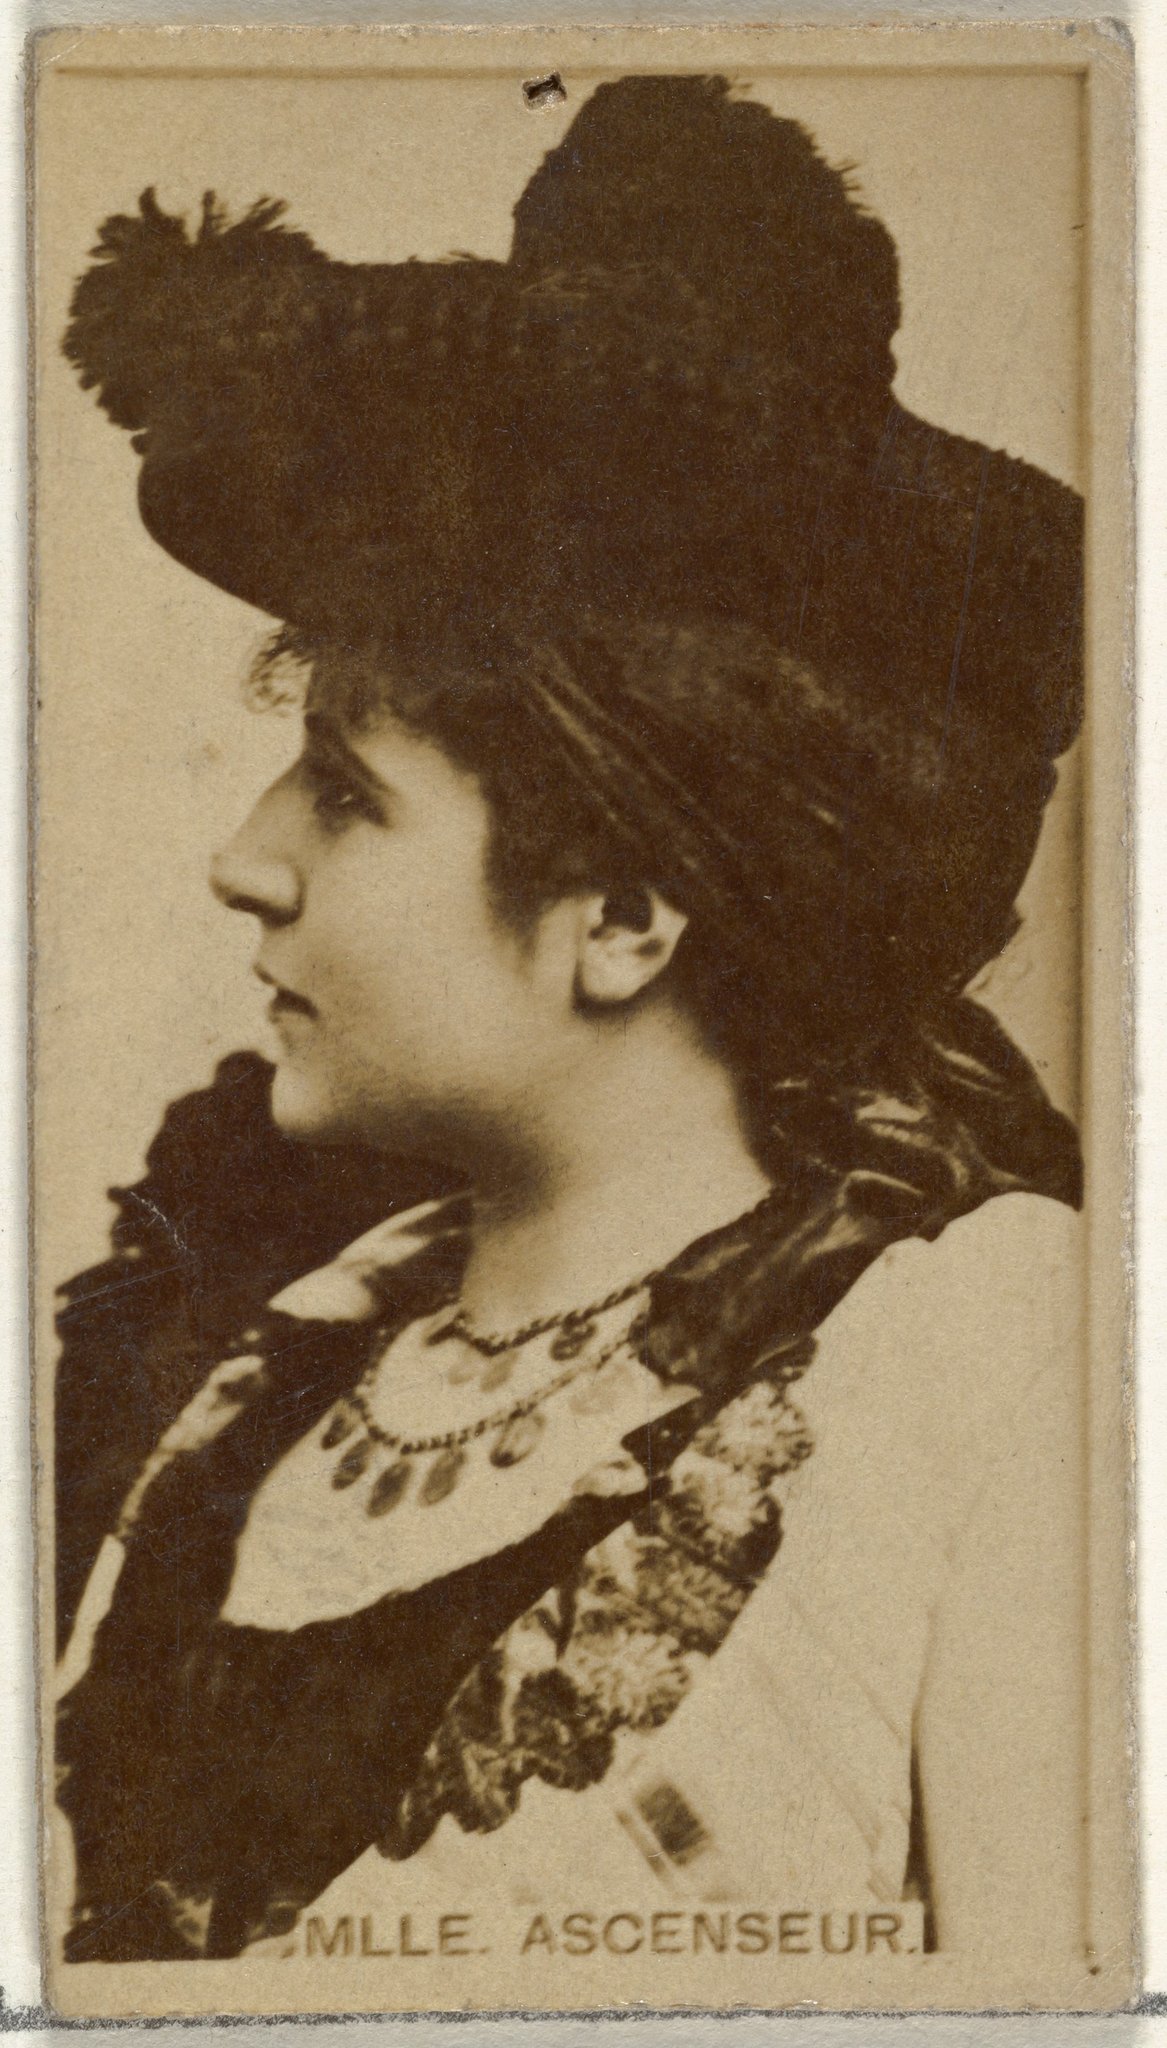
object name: photograph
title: Mlle. Ascenseur, from the Actors and Actresses series (N145-8) issued by Duke Sons & Co. to promote Duke Cigarettes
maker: w. duke, sons & co.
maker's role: publisher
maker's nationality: american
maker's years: 1870-1920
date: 1891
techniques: albumen silver print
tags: portraits,women,actresses